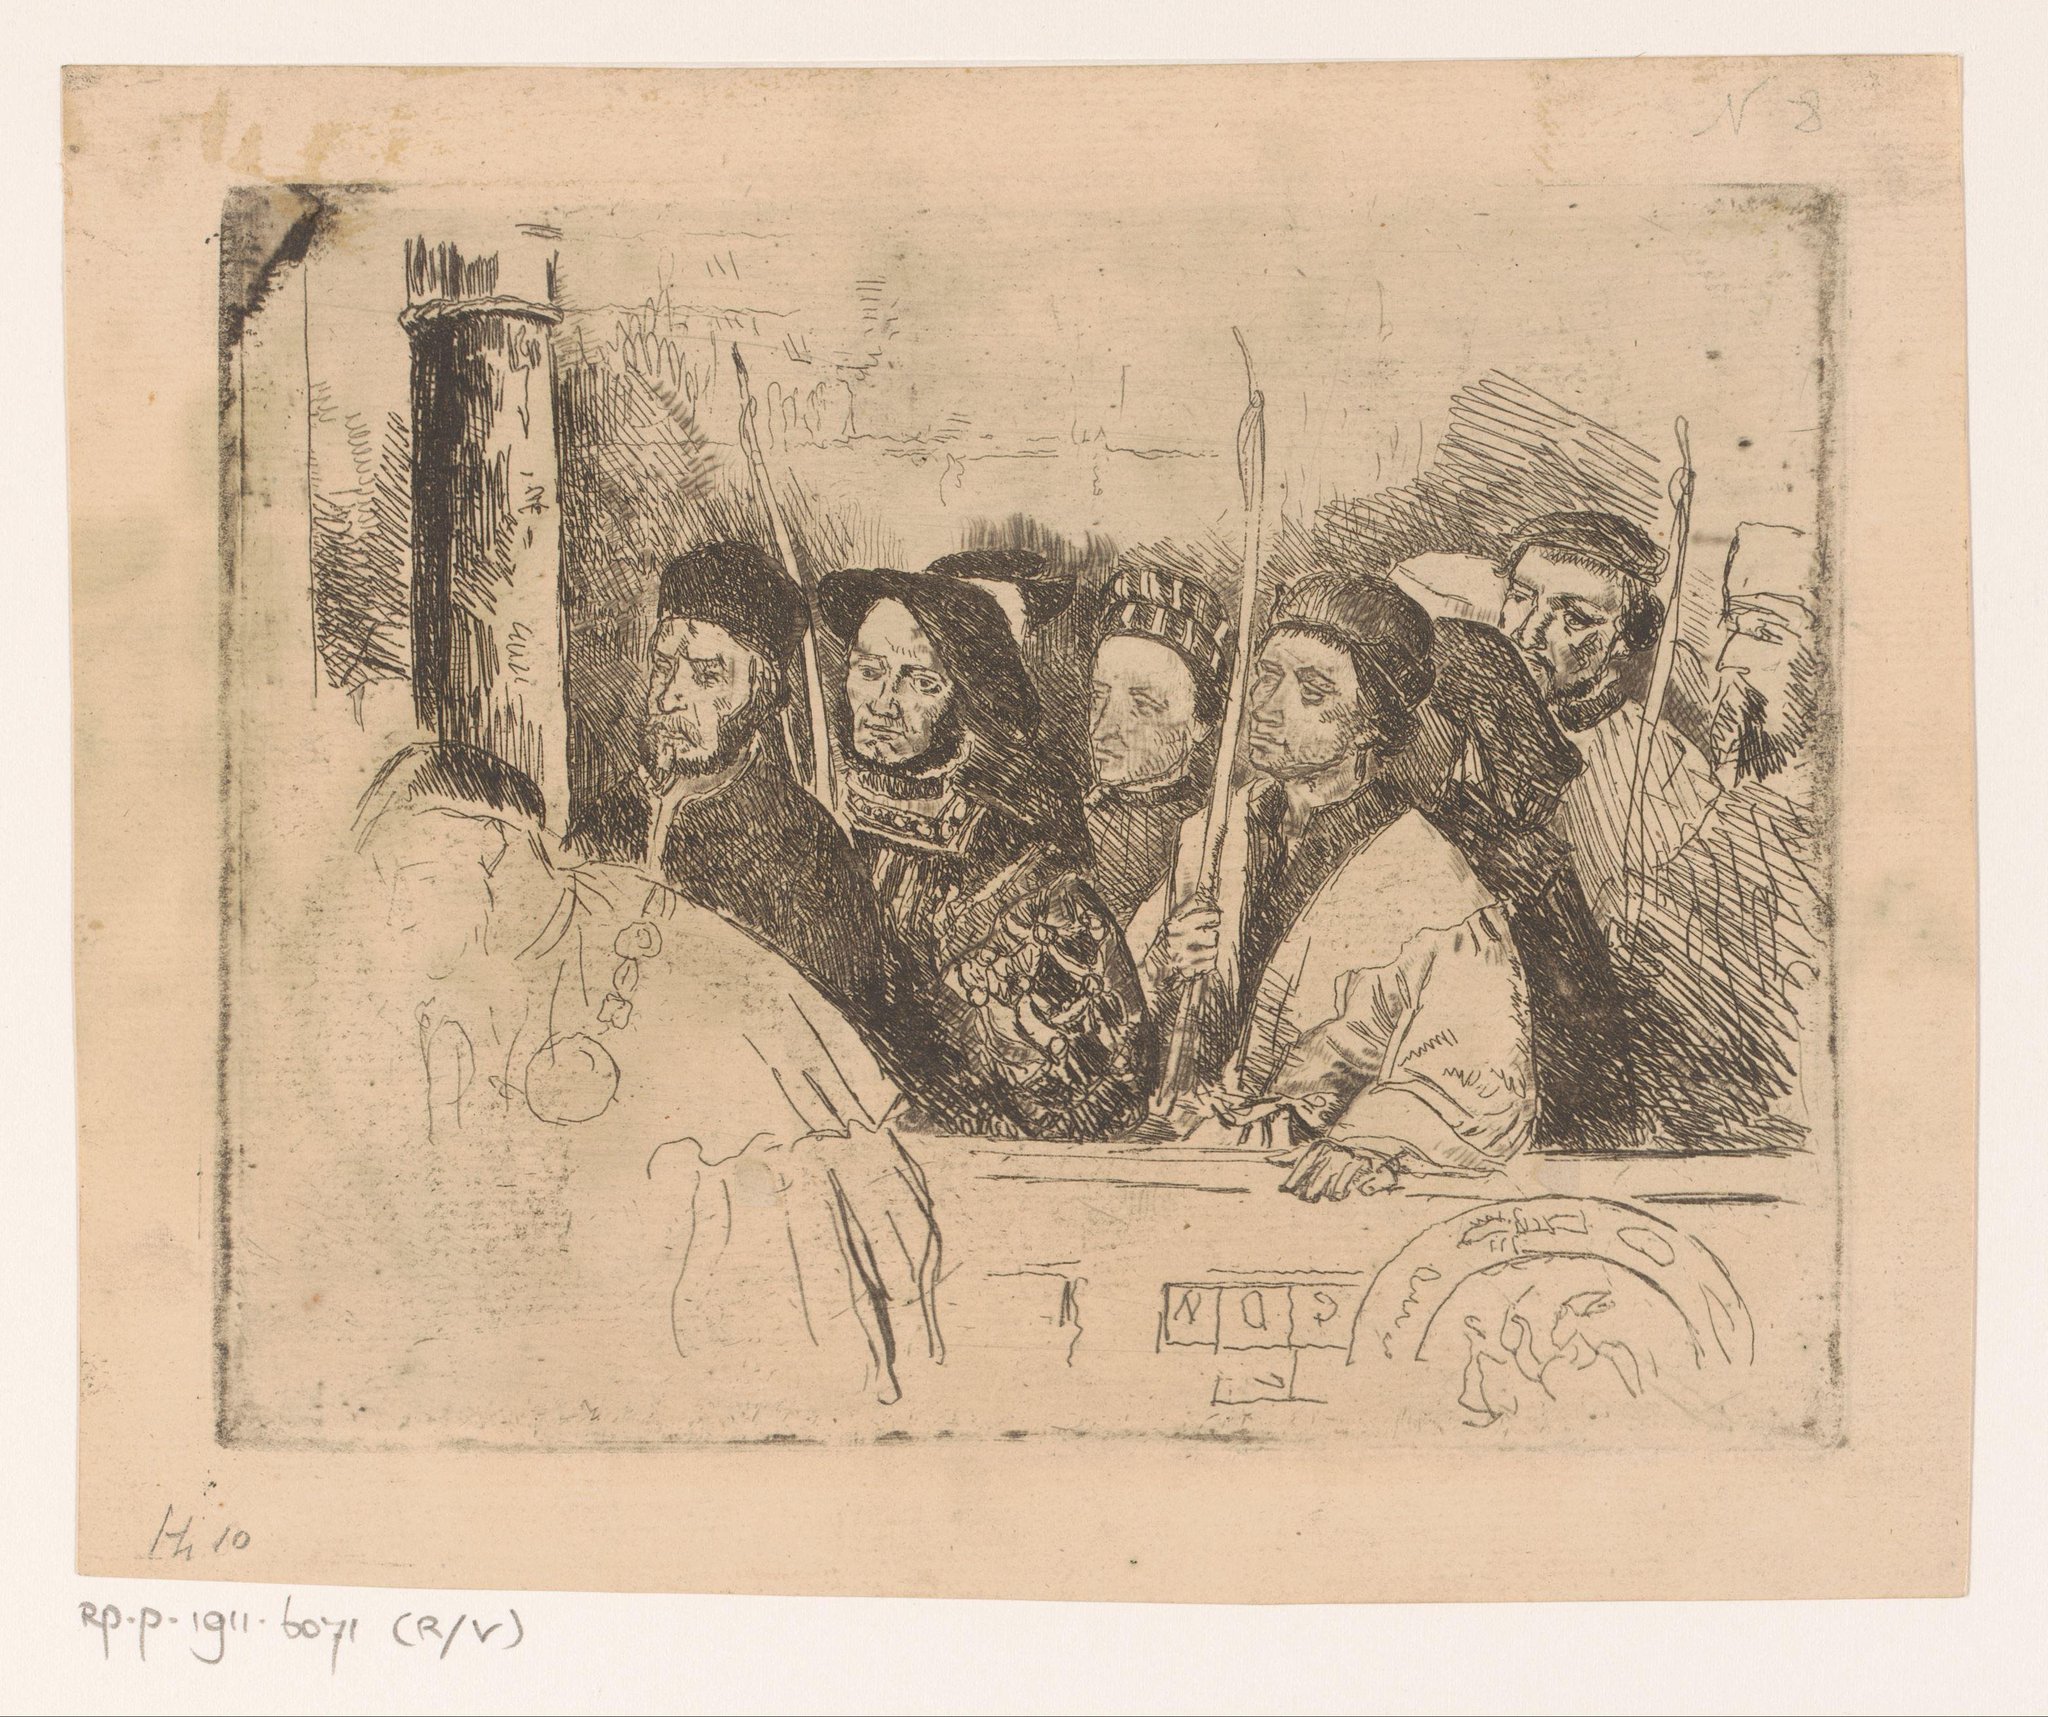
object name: print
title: Les archers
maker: henri leys (baron)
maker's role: draughtsman, painter, print maker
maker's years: 1815-1869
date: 1865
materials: paper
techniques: etching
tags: private soldier (+ citizen soldiery, civil guard, citizen militia), archer's weapons: bow, antwerp